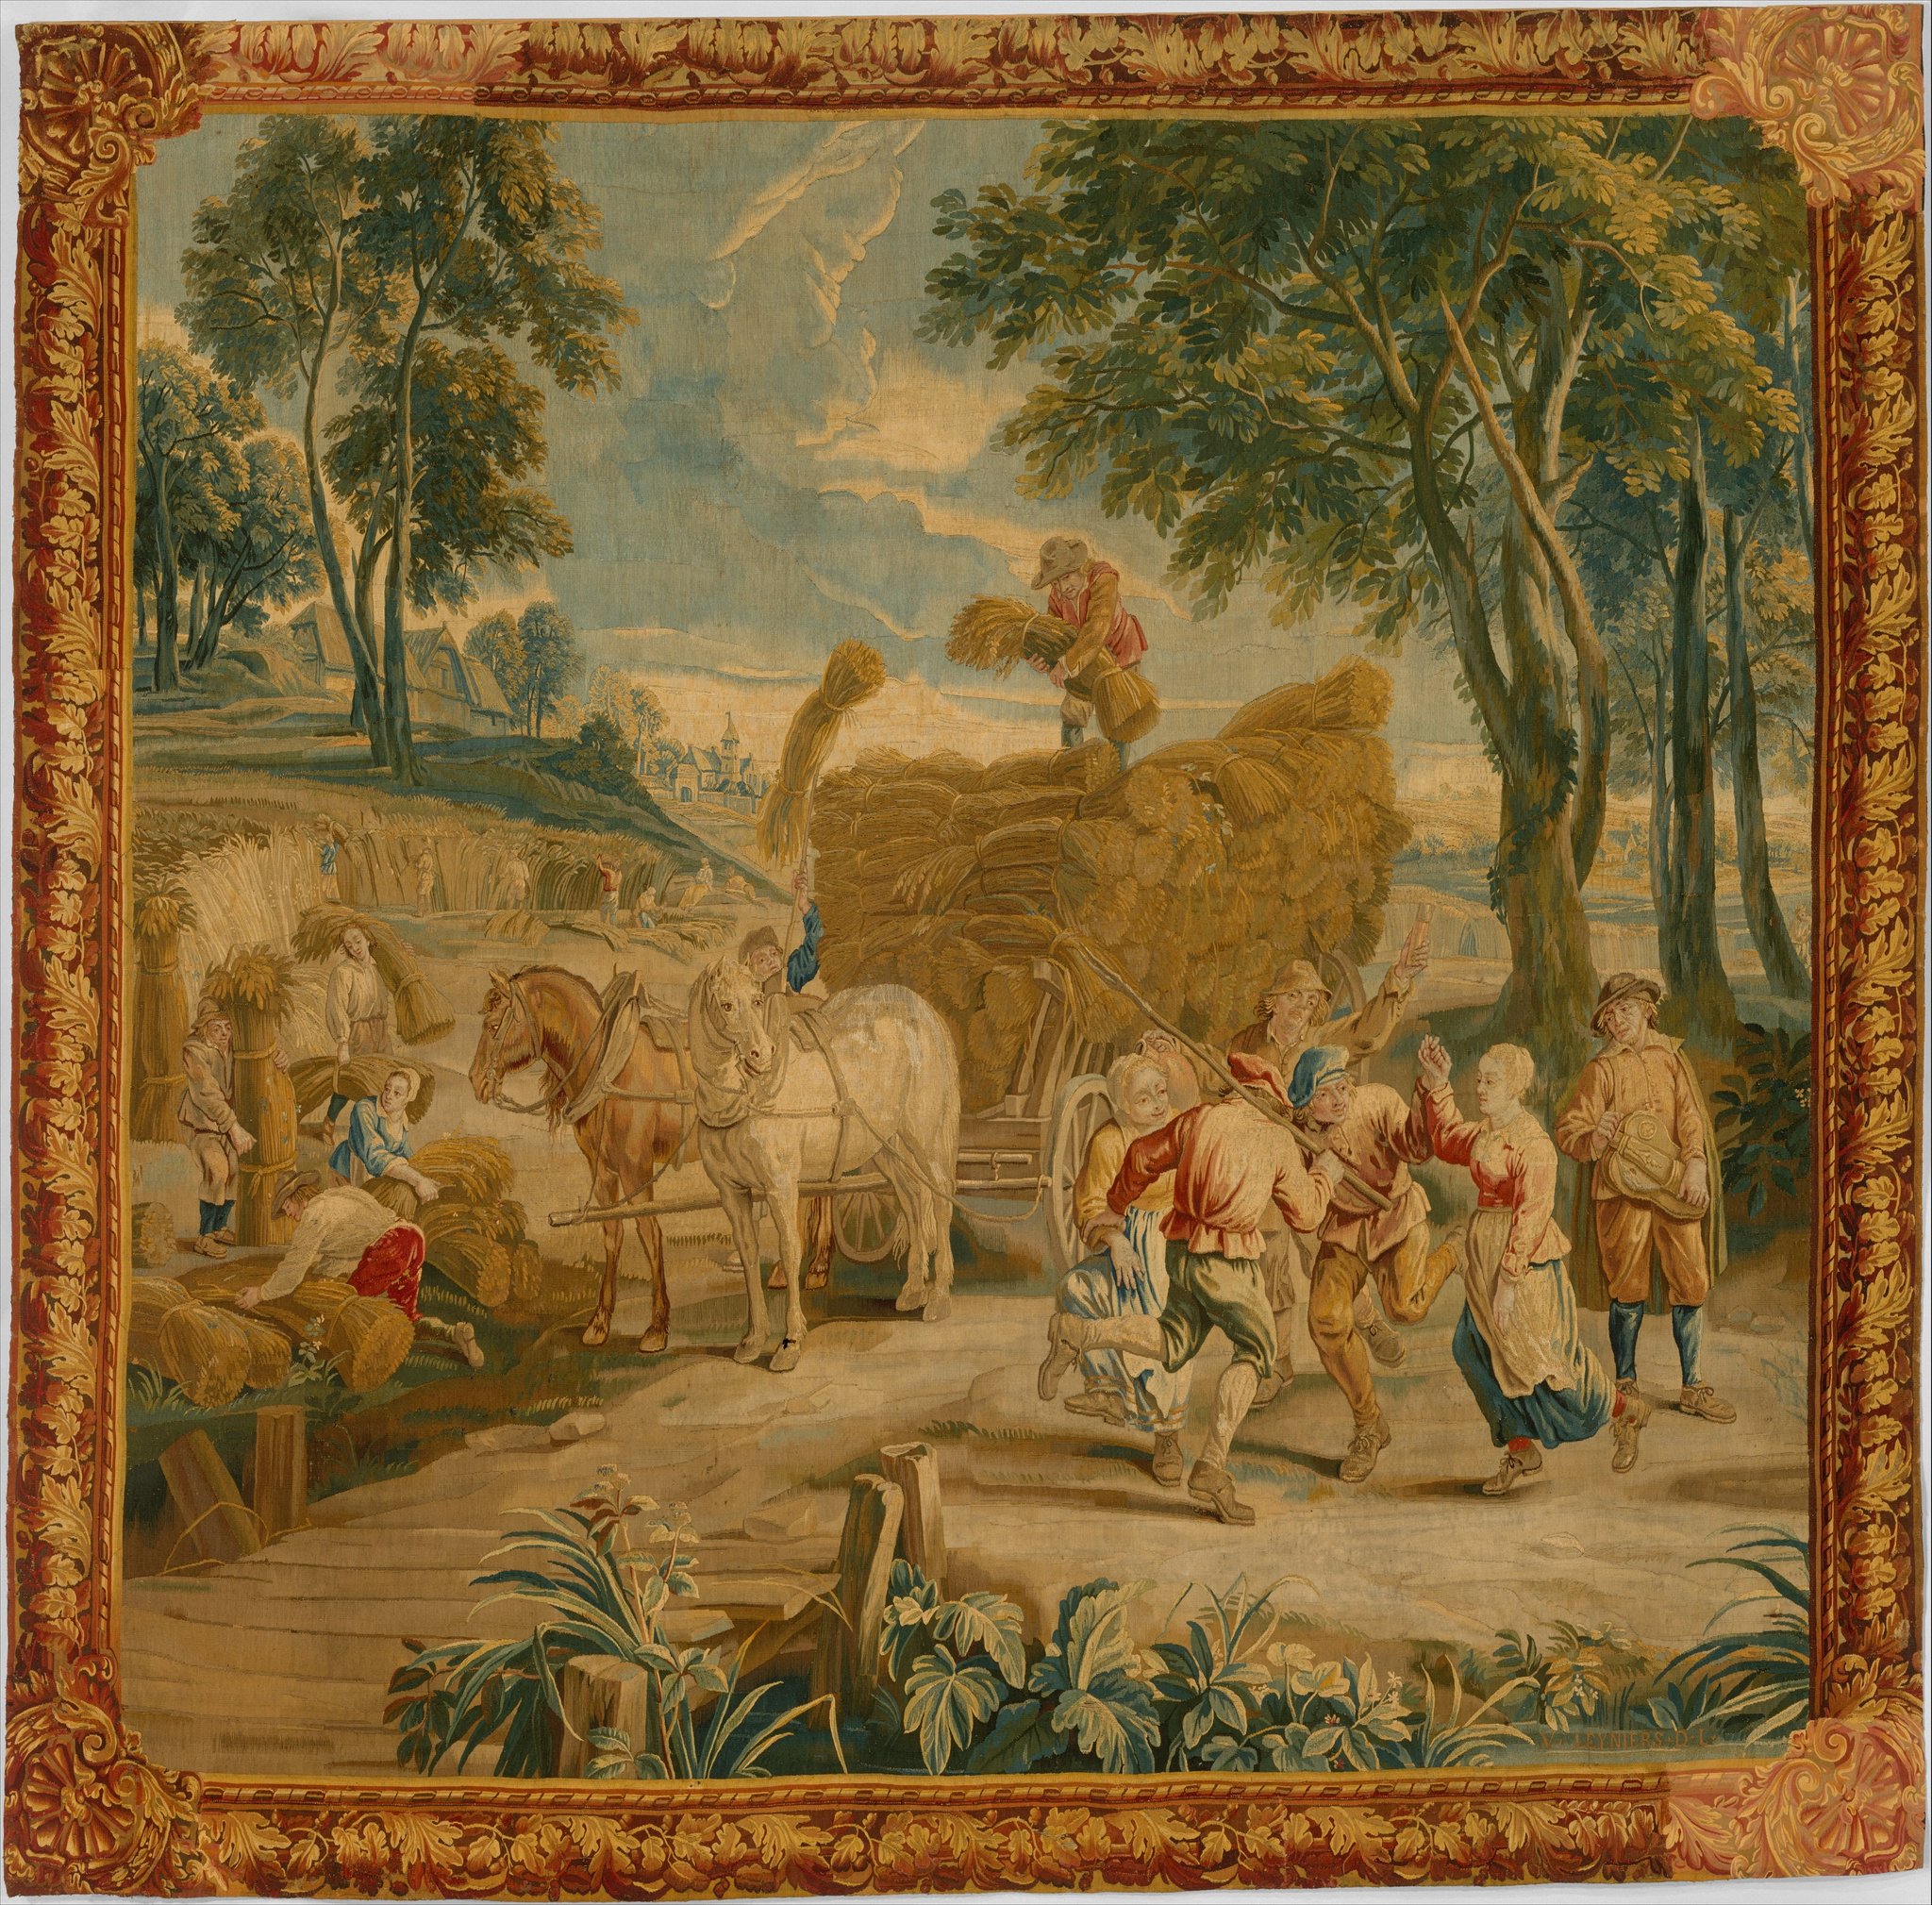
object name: tapestry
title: The Harvest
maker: urbanus leyniers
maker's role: maker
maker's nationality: flemish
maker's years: 1674-1747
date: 1712-1728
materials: silk, wool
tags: men,women,dancing,horses,carts